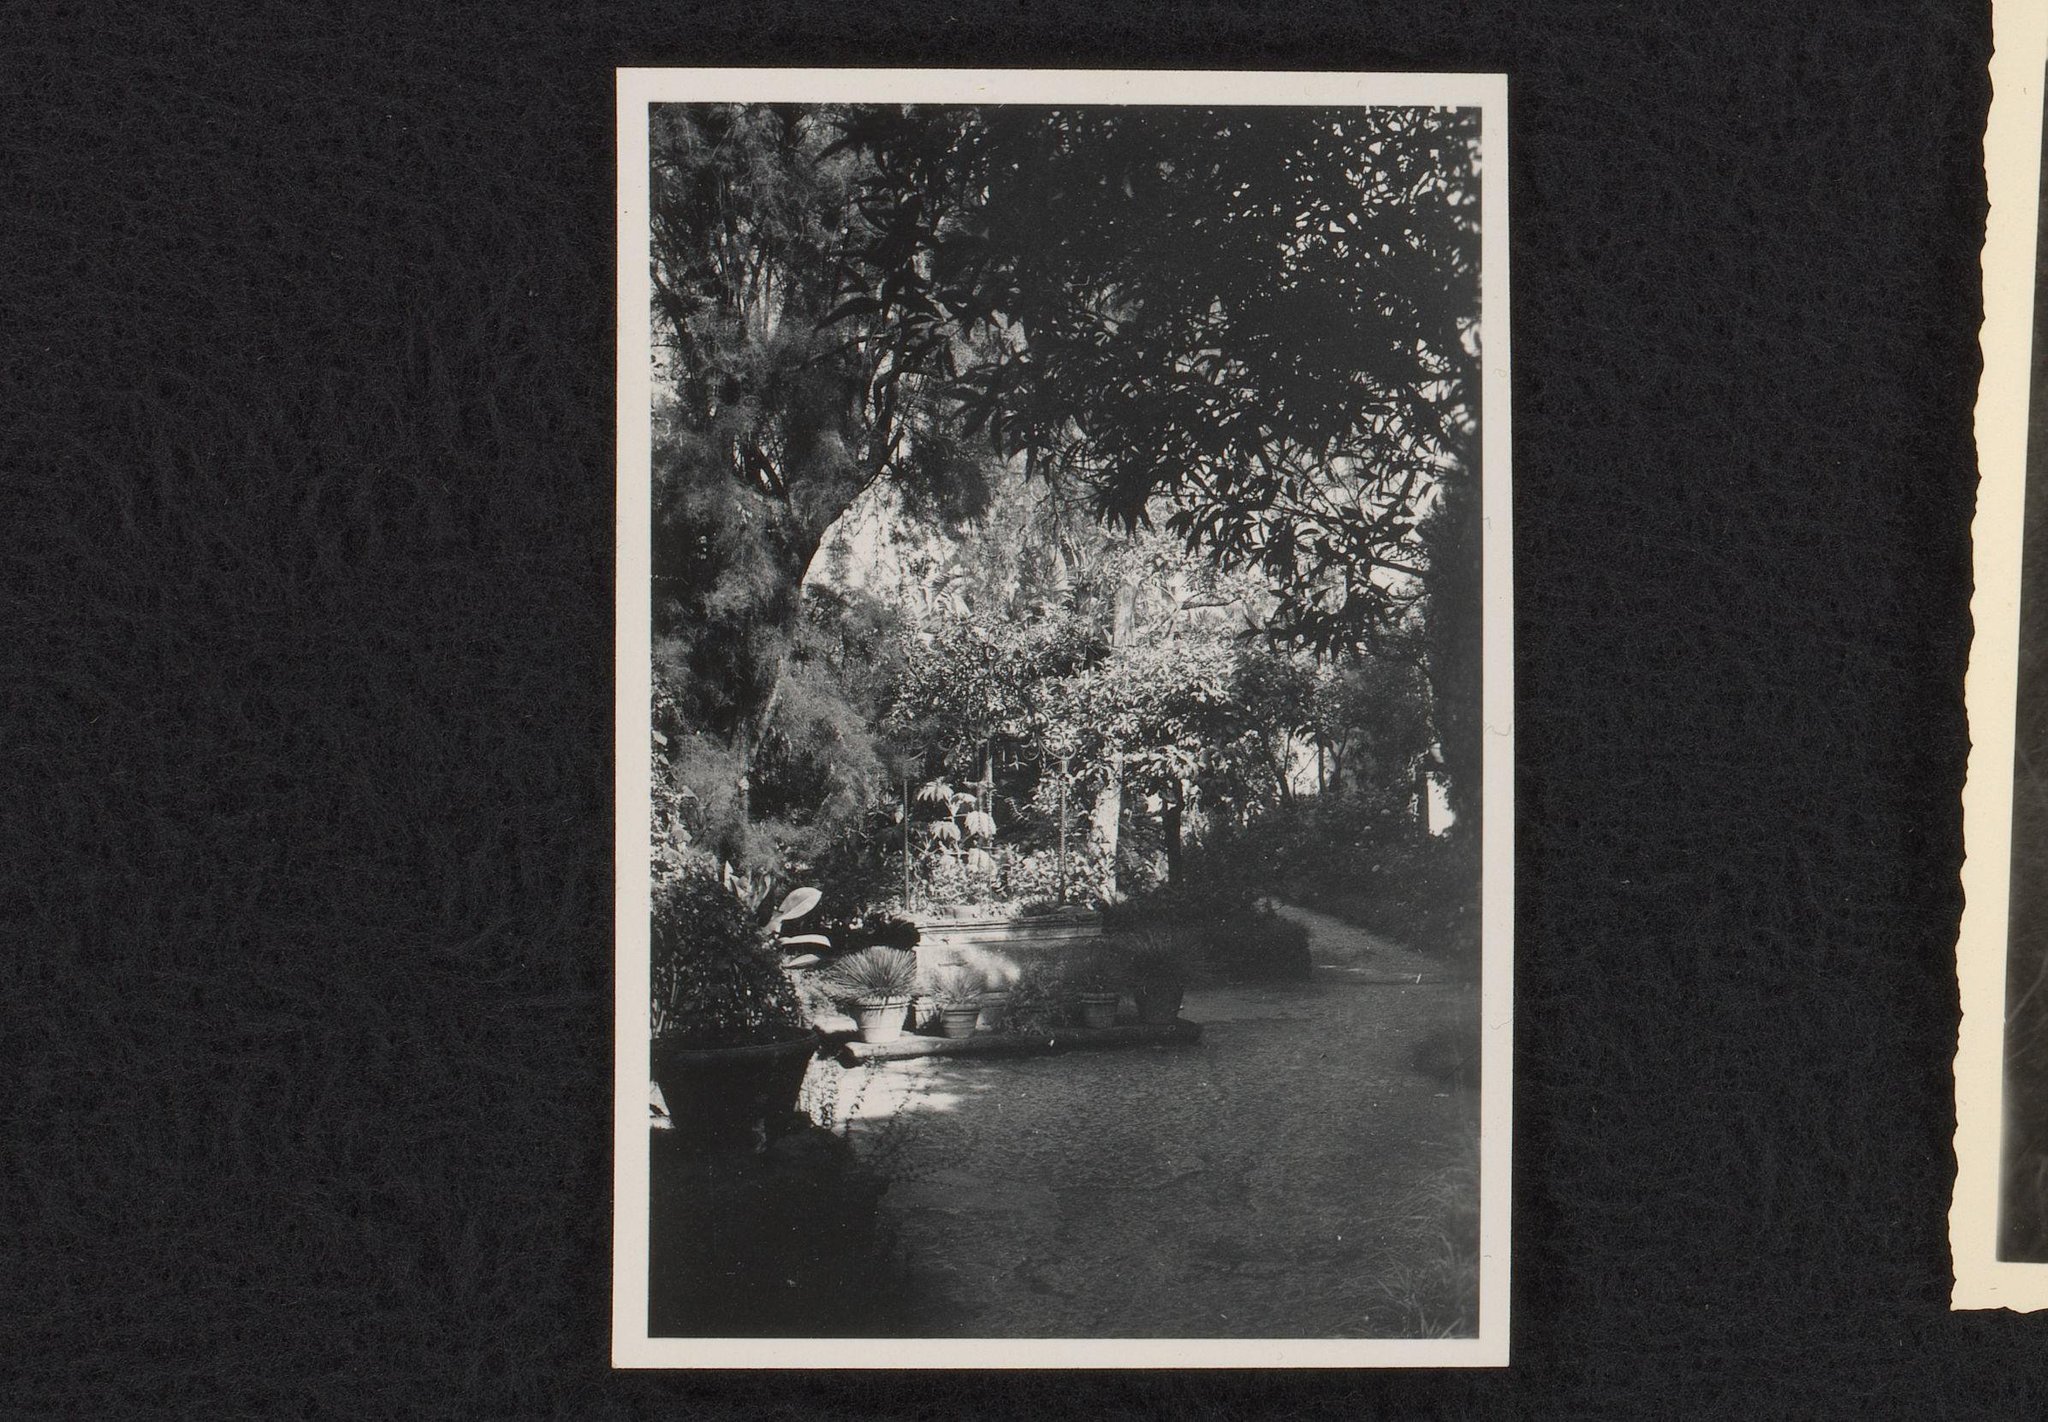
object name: ansichtkaart, prentbriefkaart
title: Binnenplaats met kloostergang, Italië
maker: Anonymous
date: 1954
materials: paper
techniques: gelatin silver print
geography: italy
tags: cloisters ~ monastery, italy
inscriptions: number: ‘31’